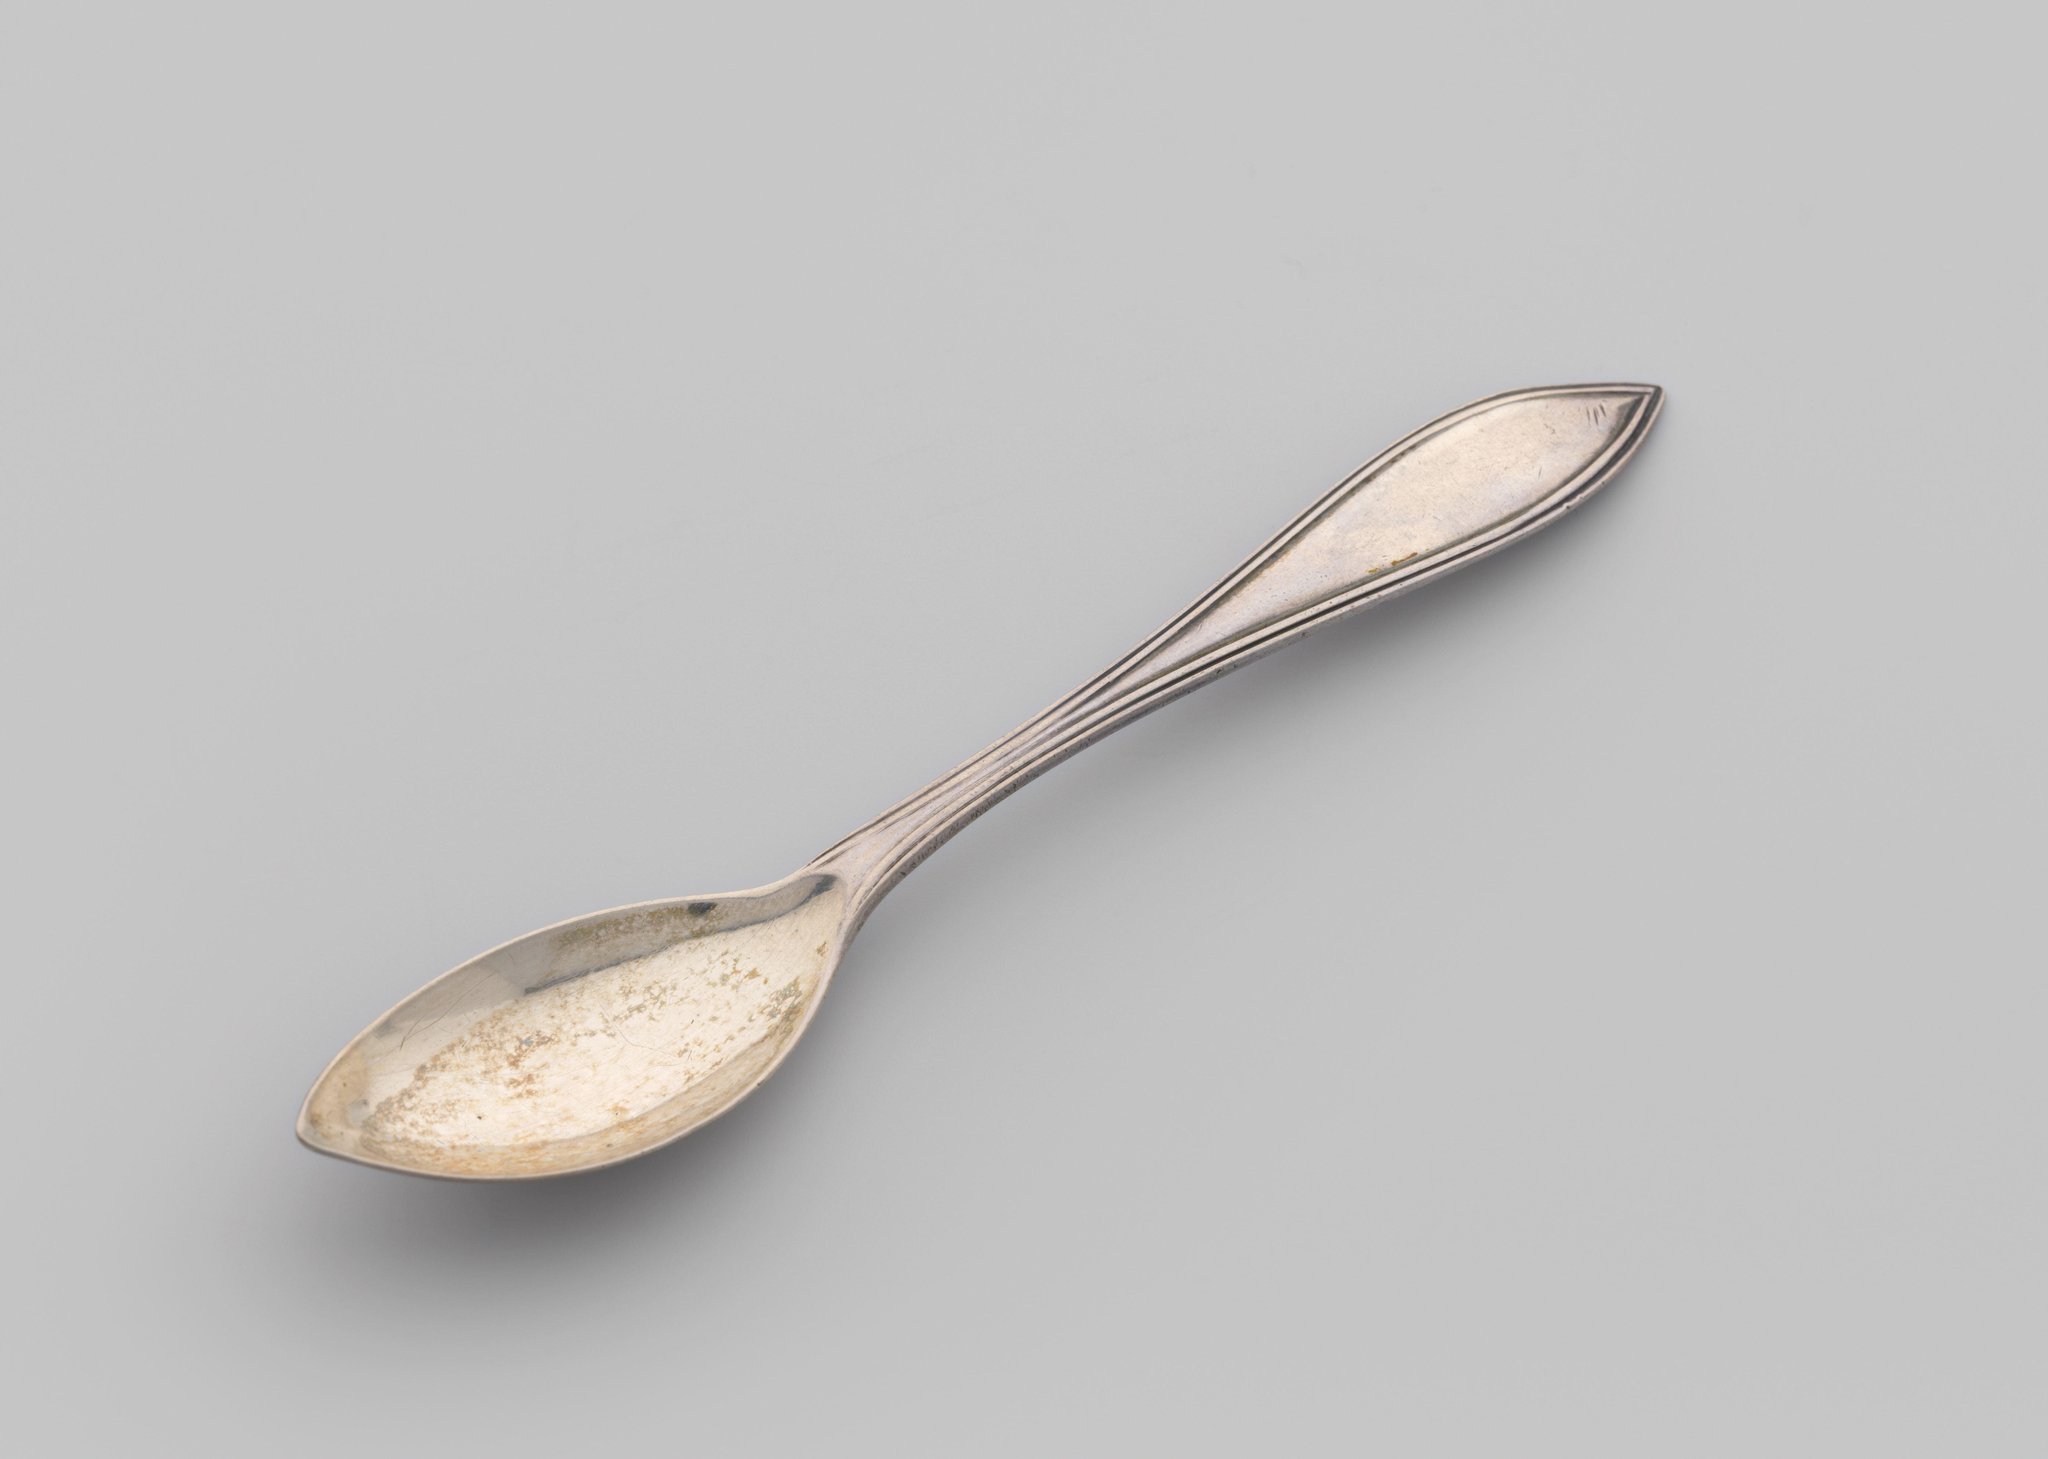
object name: spoon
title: Theelepel van zilver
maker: jan woortman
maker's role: silversmith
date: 1806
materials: silver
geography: amsterdam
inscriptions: mark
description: Theelepel van zilver, met een spits ovale bak. De platte, gebogen steel verbreedt zich naar het spitse uiteinde dat omgeven wordt door een filetrand.